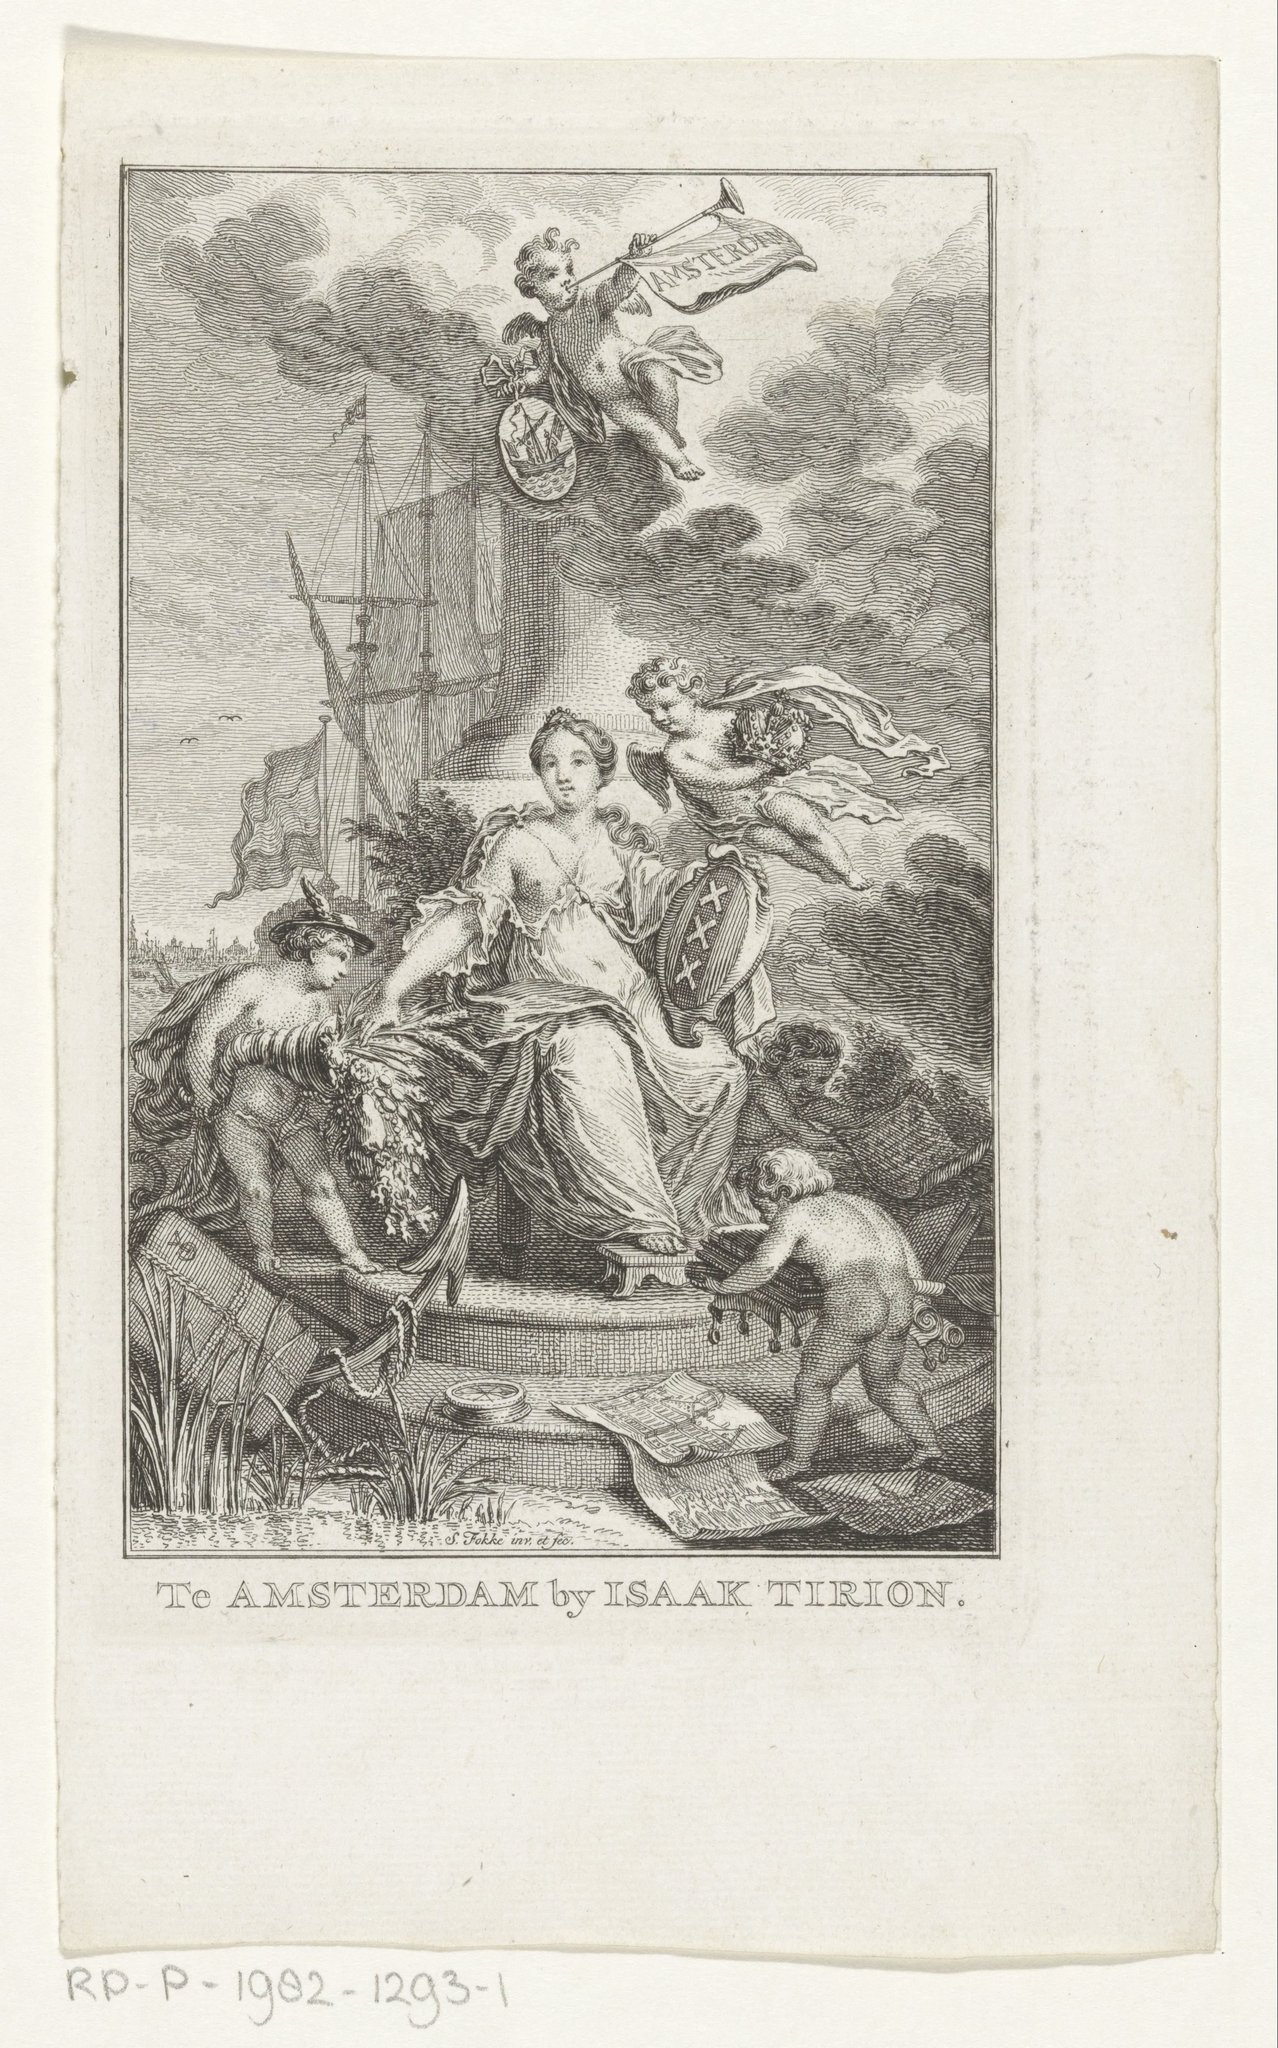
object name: print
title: Amsterdamse stedenmaagd omringd door putti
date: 1725-1766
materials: paper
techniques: etching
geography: amsterdam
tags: personification of a city, town-patron(ess), cupids: 'amores', 'amoretti', 'putti', amsterdam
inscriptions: collector's mark: Lugt 2228, collector's mark: Lugt 2760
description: Op een verhoging zit de Amsterdamse stedenmaagd met het wapen van Amsterdam. Ze heeft haar arm uitgestrekt naar de hoorn des overvloeds die wordt vastgehouden door een putto met gevleugelde helm. Rechts van haar vliegt een putto met een kroon in zijn handen, voor haar knielt een putto met een boek op een kussen. Boven in de lucht wordt de bazuin geblazen door een putto die een medaillon met de beeltenis van een zeilschip vasthoudt.